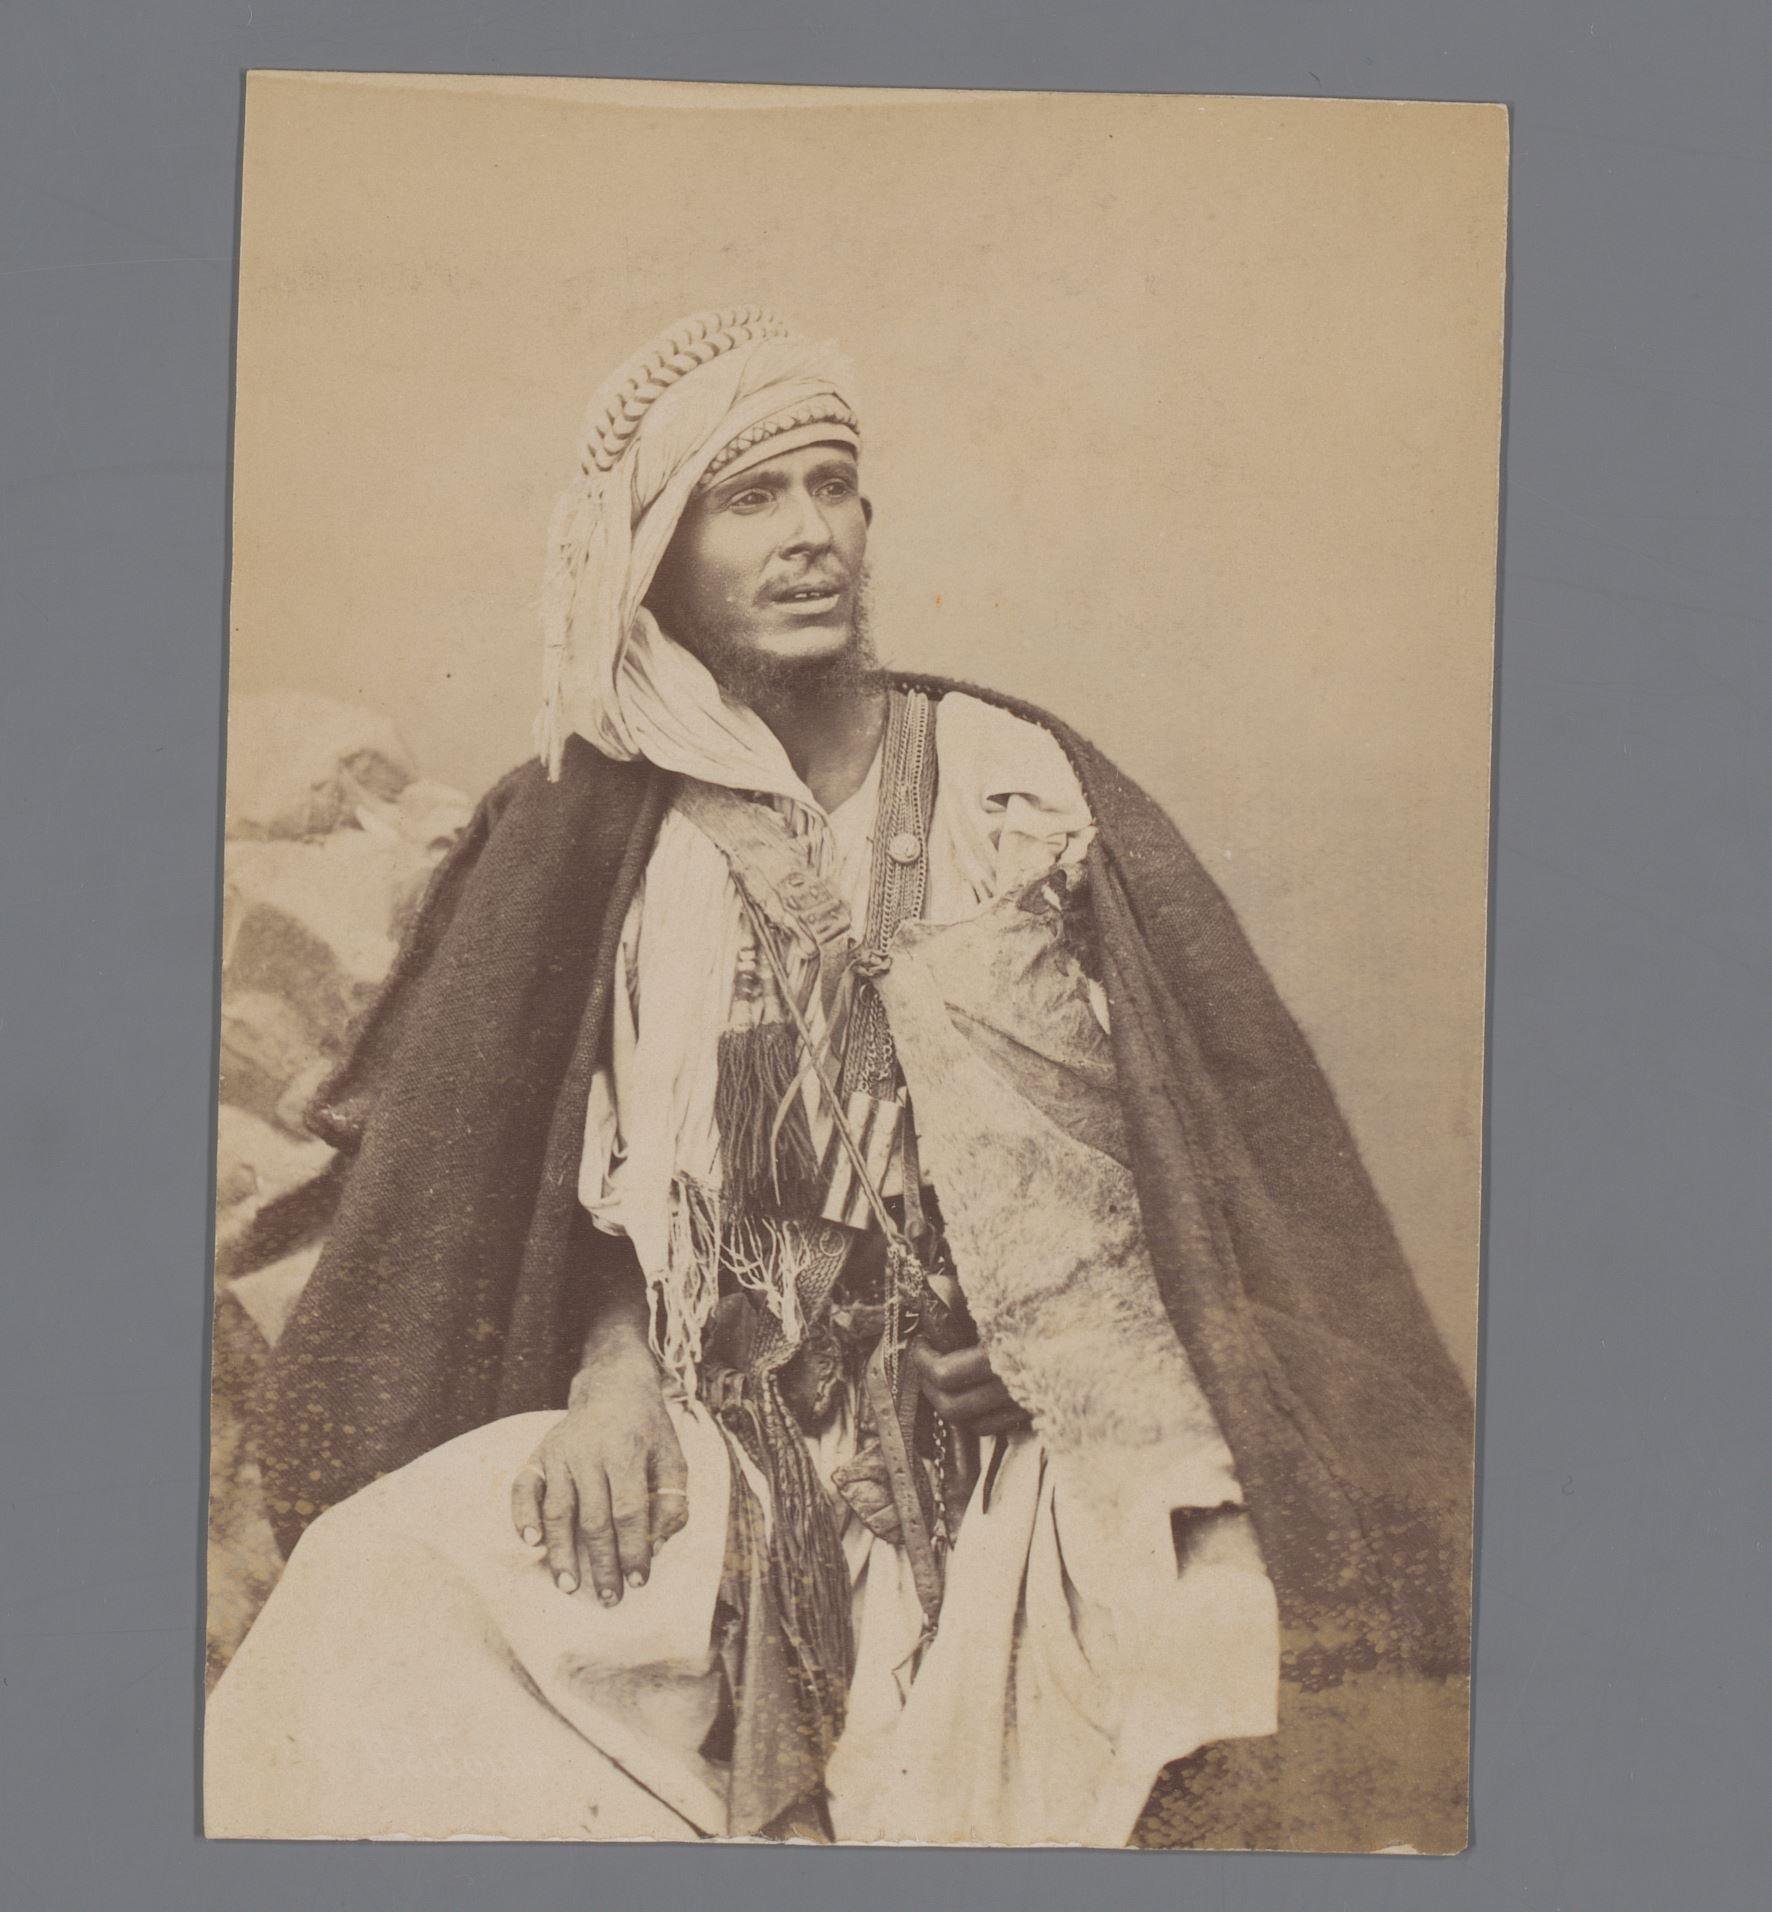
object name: photograph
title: Zittende man met pijp, Egypte?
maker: Anonymous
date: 1880-1900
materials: paper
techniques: albumen print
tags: egypte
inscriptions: inscription: ‘Bedouin’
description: Zittende man in inheemse kleding/bedouin, Egypte [?].